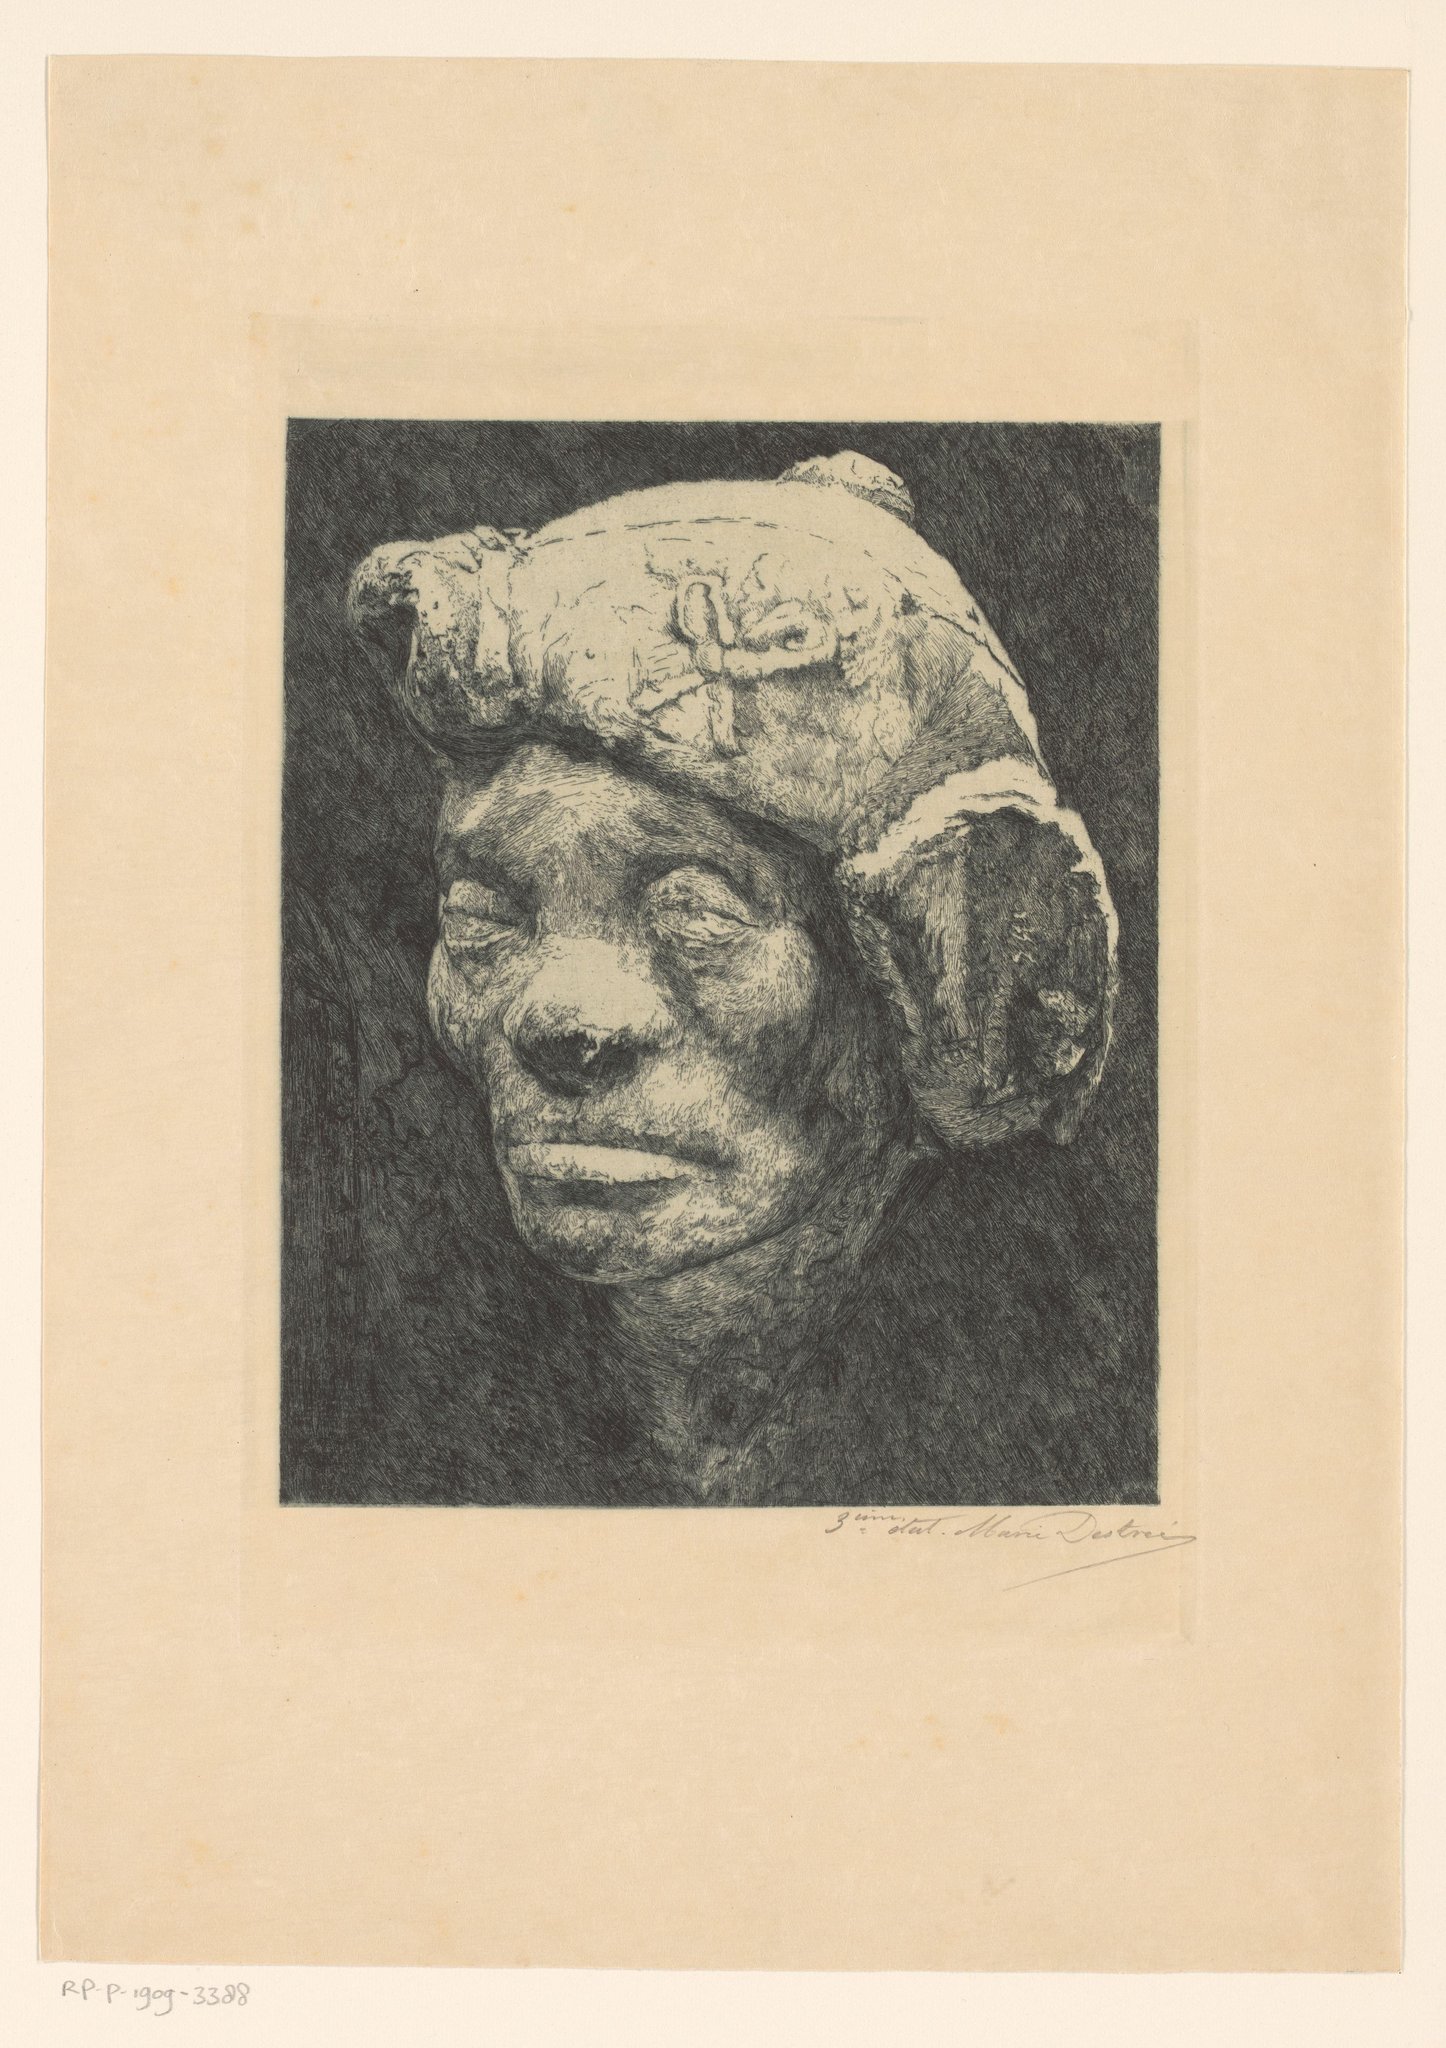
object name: print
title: Hoofd van een mens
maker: marie danse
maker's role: print maker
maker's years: 1867-1942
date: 1889-1909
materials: paper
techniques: etching, intaglio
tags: head (human)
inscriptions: collector's mark: Lugt 2228, inscription: ‘3eme etat’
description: Prent is waarschijnlijk gemaakt naar een vijftiende-eeuwse sculptuur.